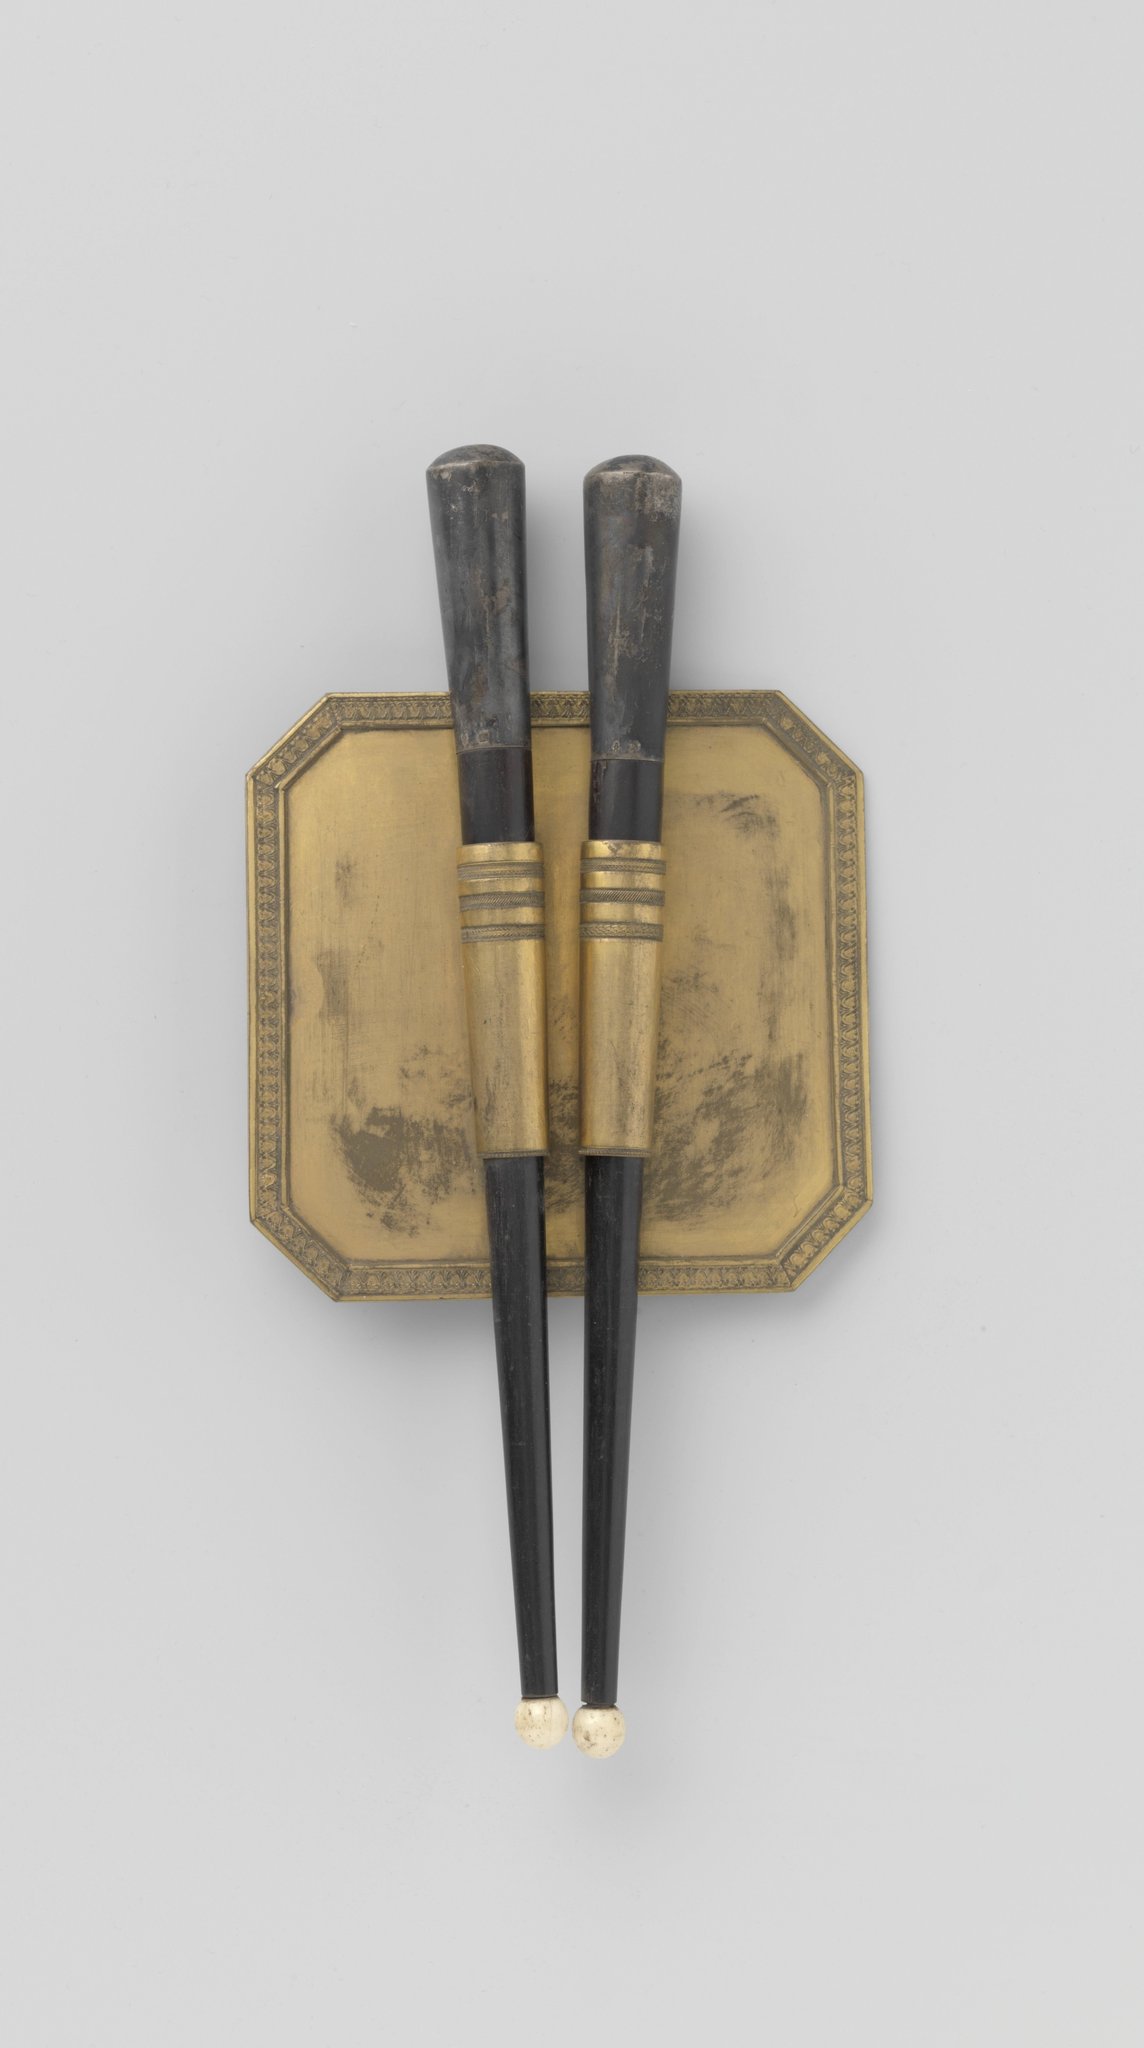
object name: stick plate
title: Stokplaat van verguld koper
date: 1823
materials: copper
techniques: gilding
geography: netherlands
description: Stokplaat voor een slagband van een tamboer-majoor.